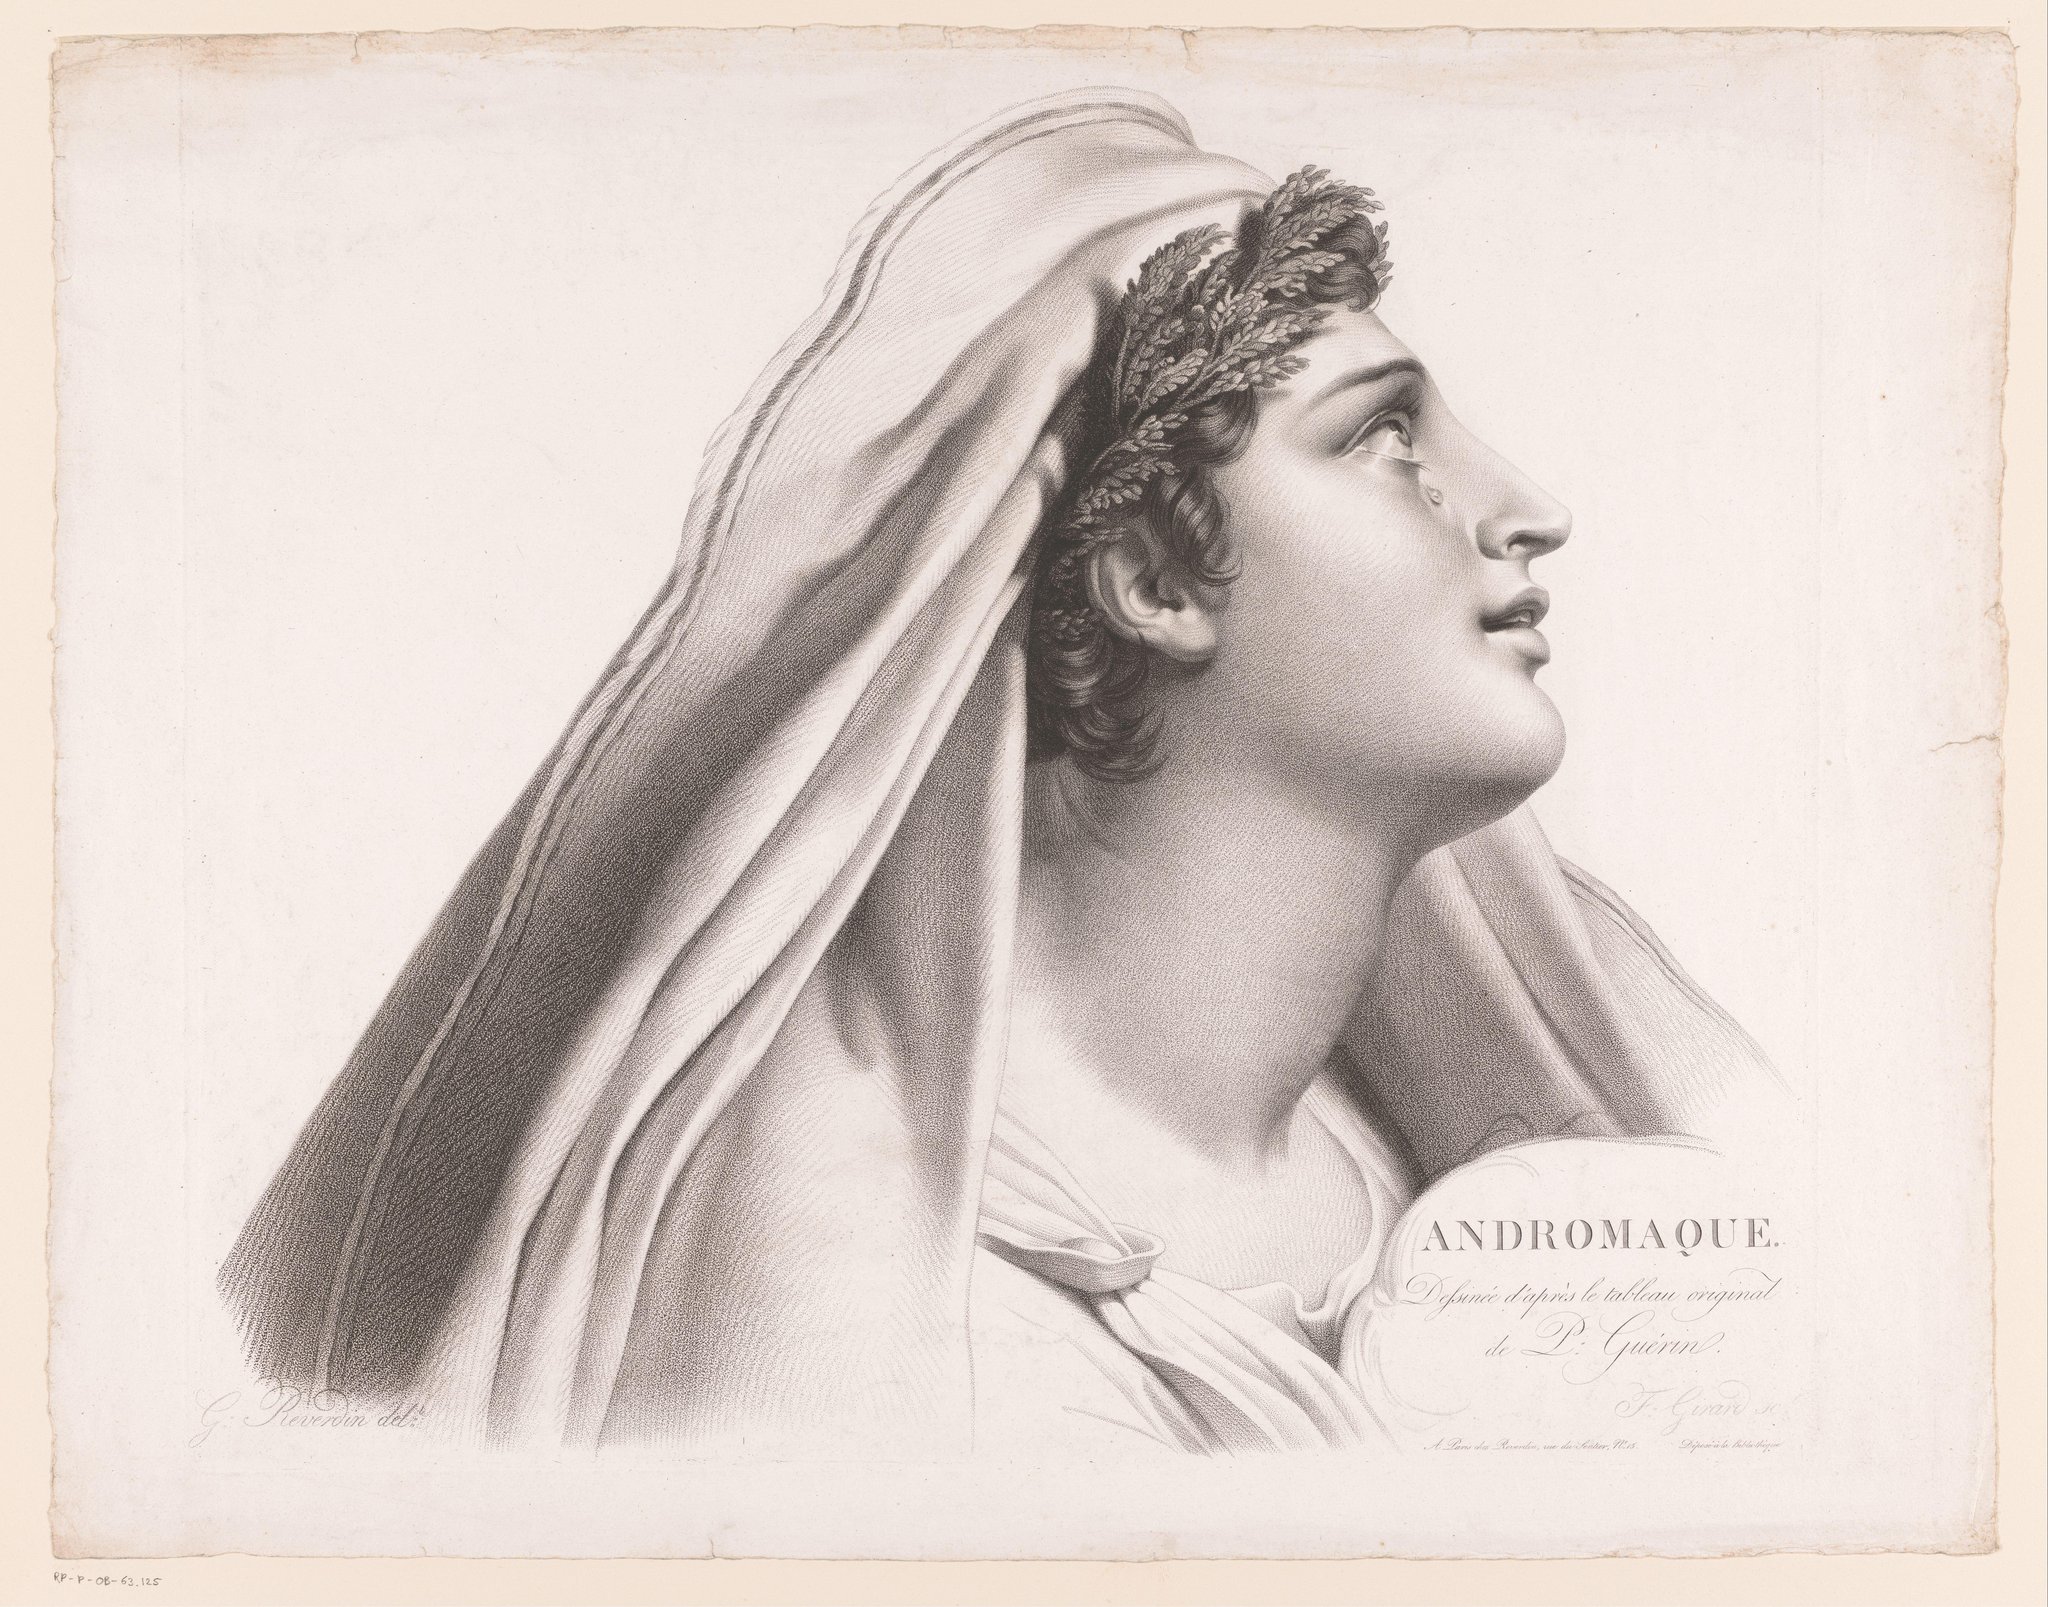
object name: print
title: Andromaque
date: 1797-1828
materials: paper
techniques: engraving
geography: france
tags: weeping, (story of) andromache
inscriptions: collector's mark: Lugt 2228, : ‘Déposé à la Bibliothèque’